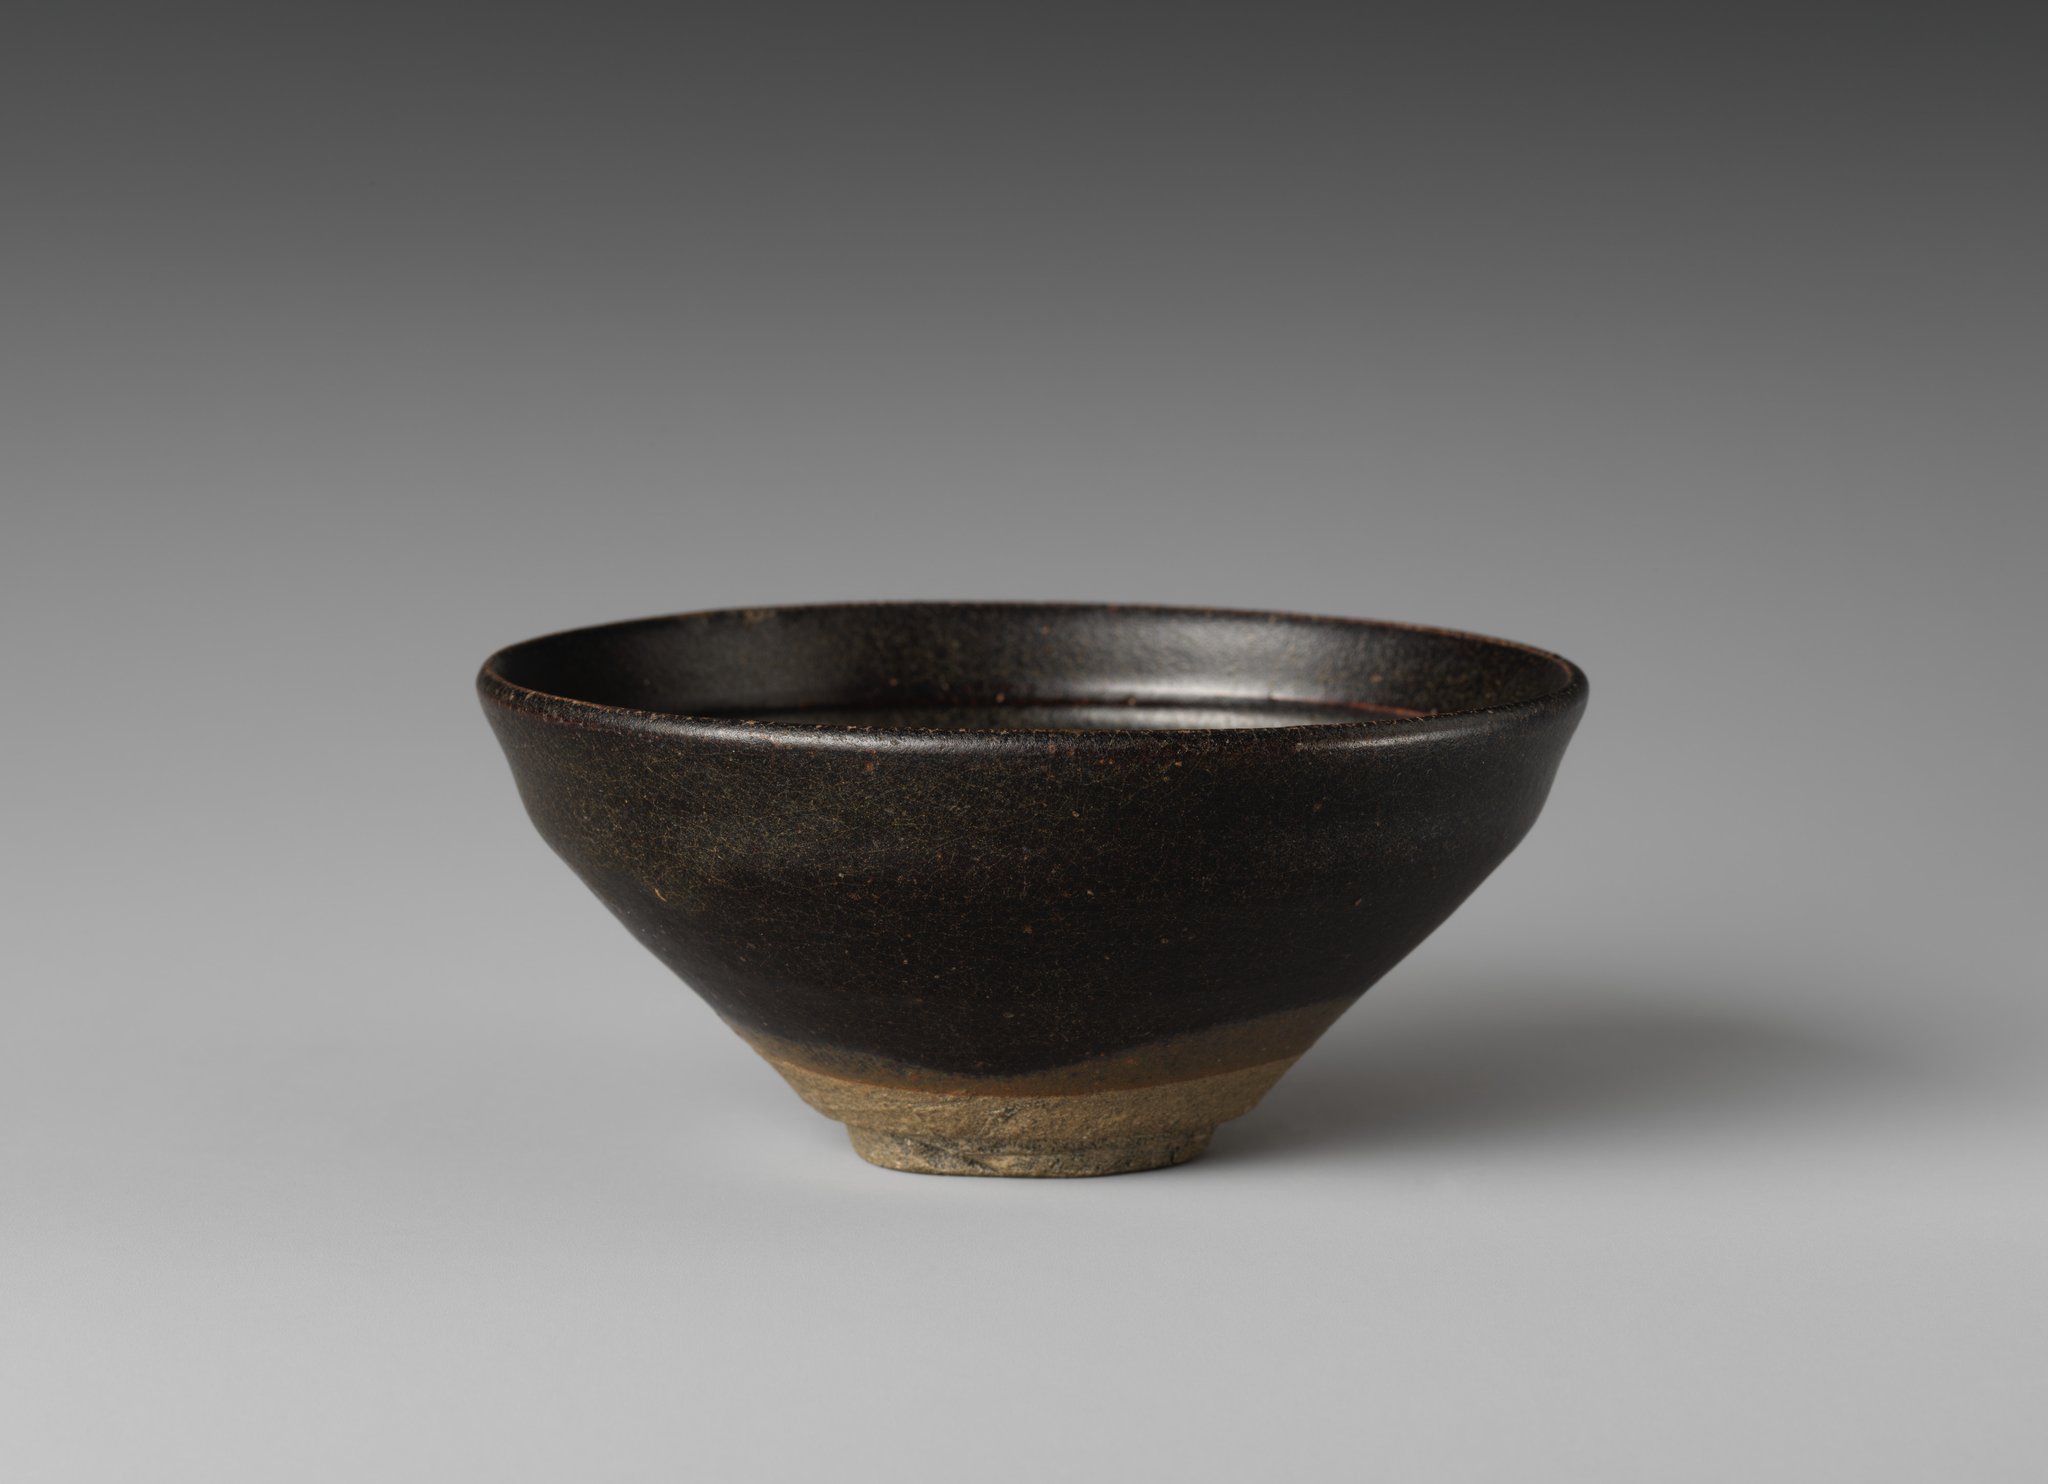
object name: teabowl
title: Tea bowl with plum decoration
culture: chinese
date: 1201-1400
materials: glaze, stoneware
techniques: painting